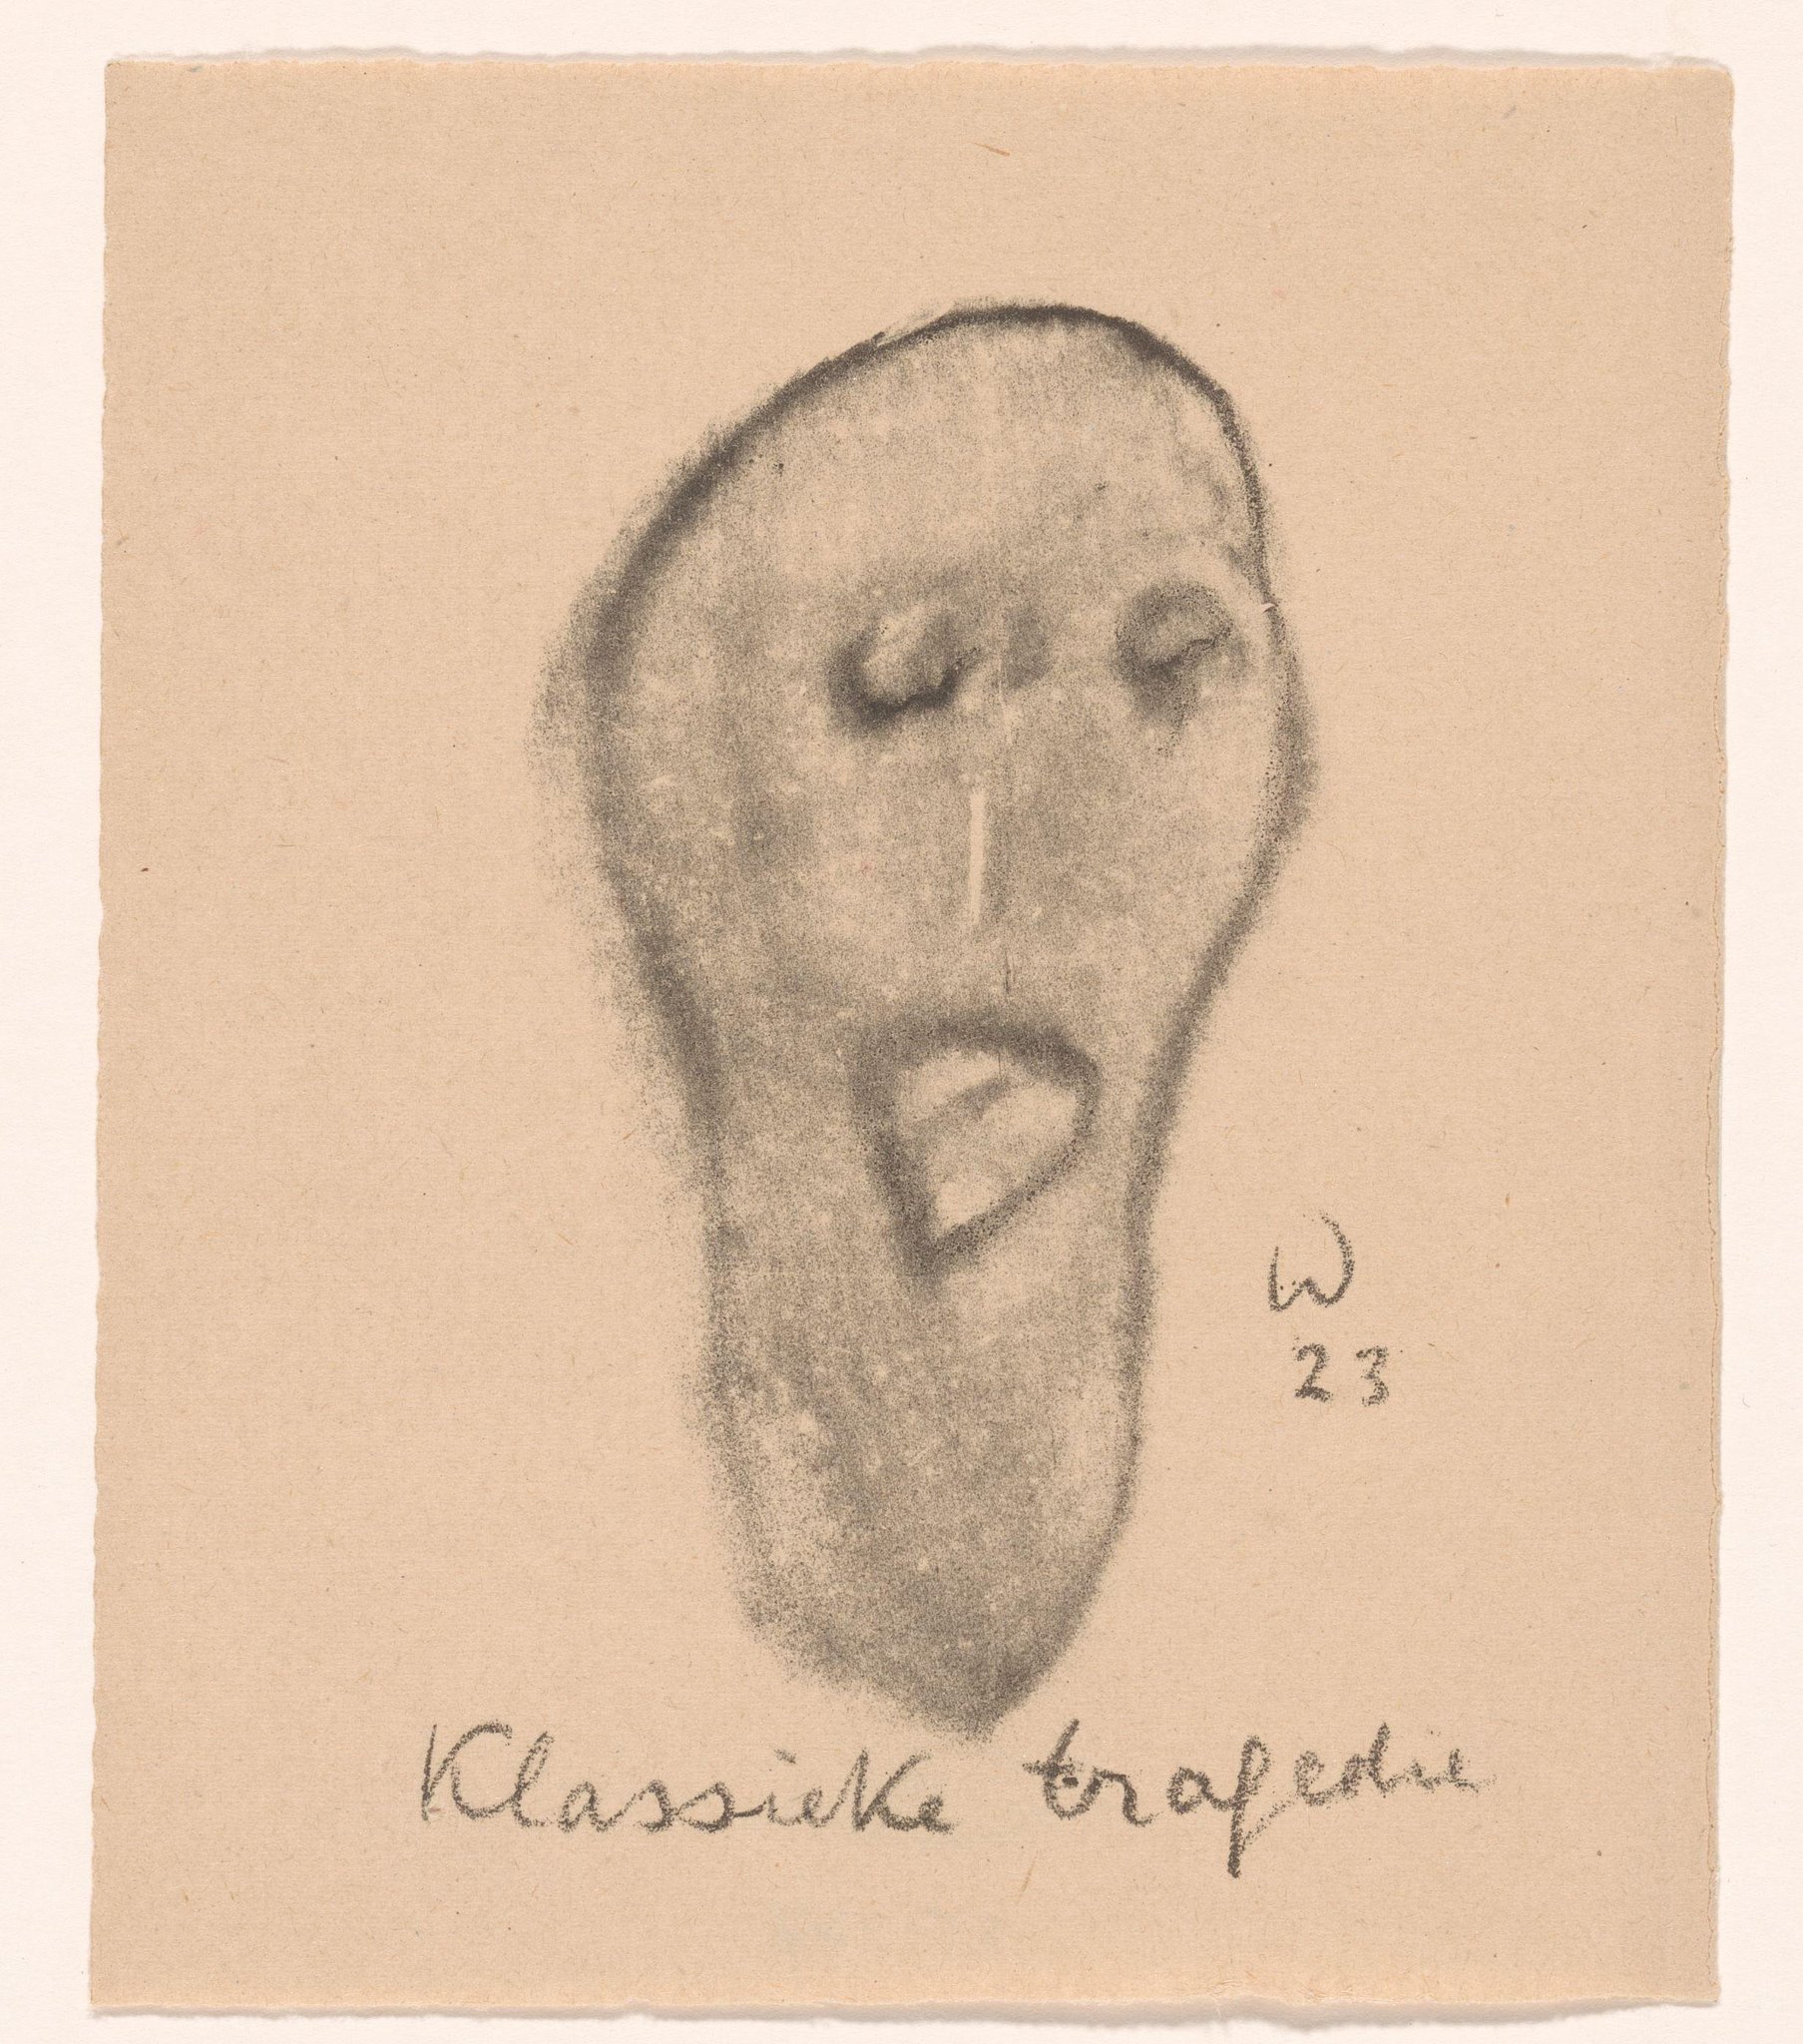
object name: print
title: Idealisten II en verdere Kanttekeningen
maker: erich wichmann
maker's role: print maker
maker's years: 1890-1929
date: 1923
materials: paper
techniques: lithograph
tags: caricatures (human types)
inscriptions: collector's mark: Lugt 2228